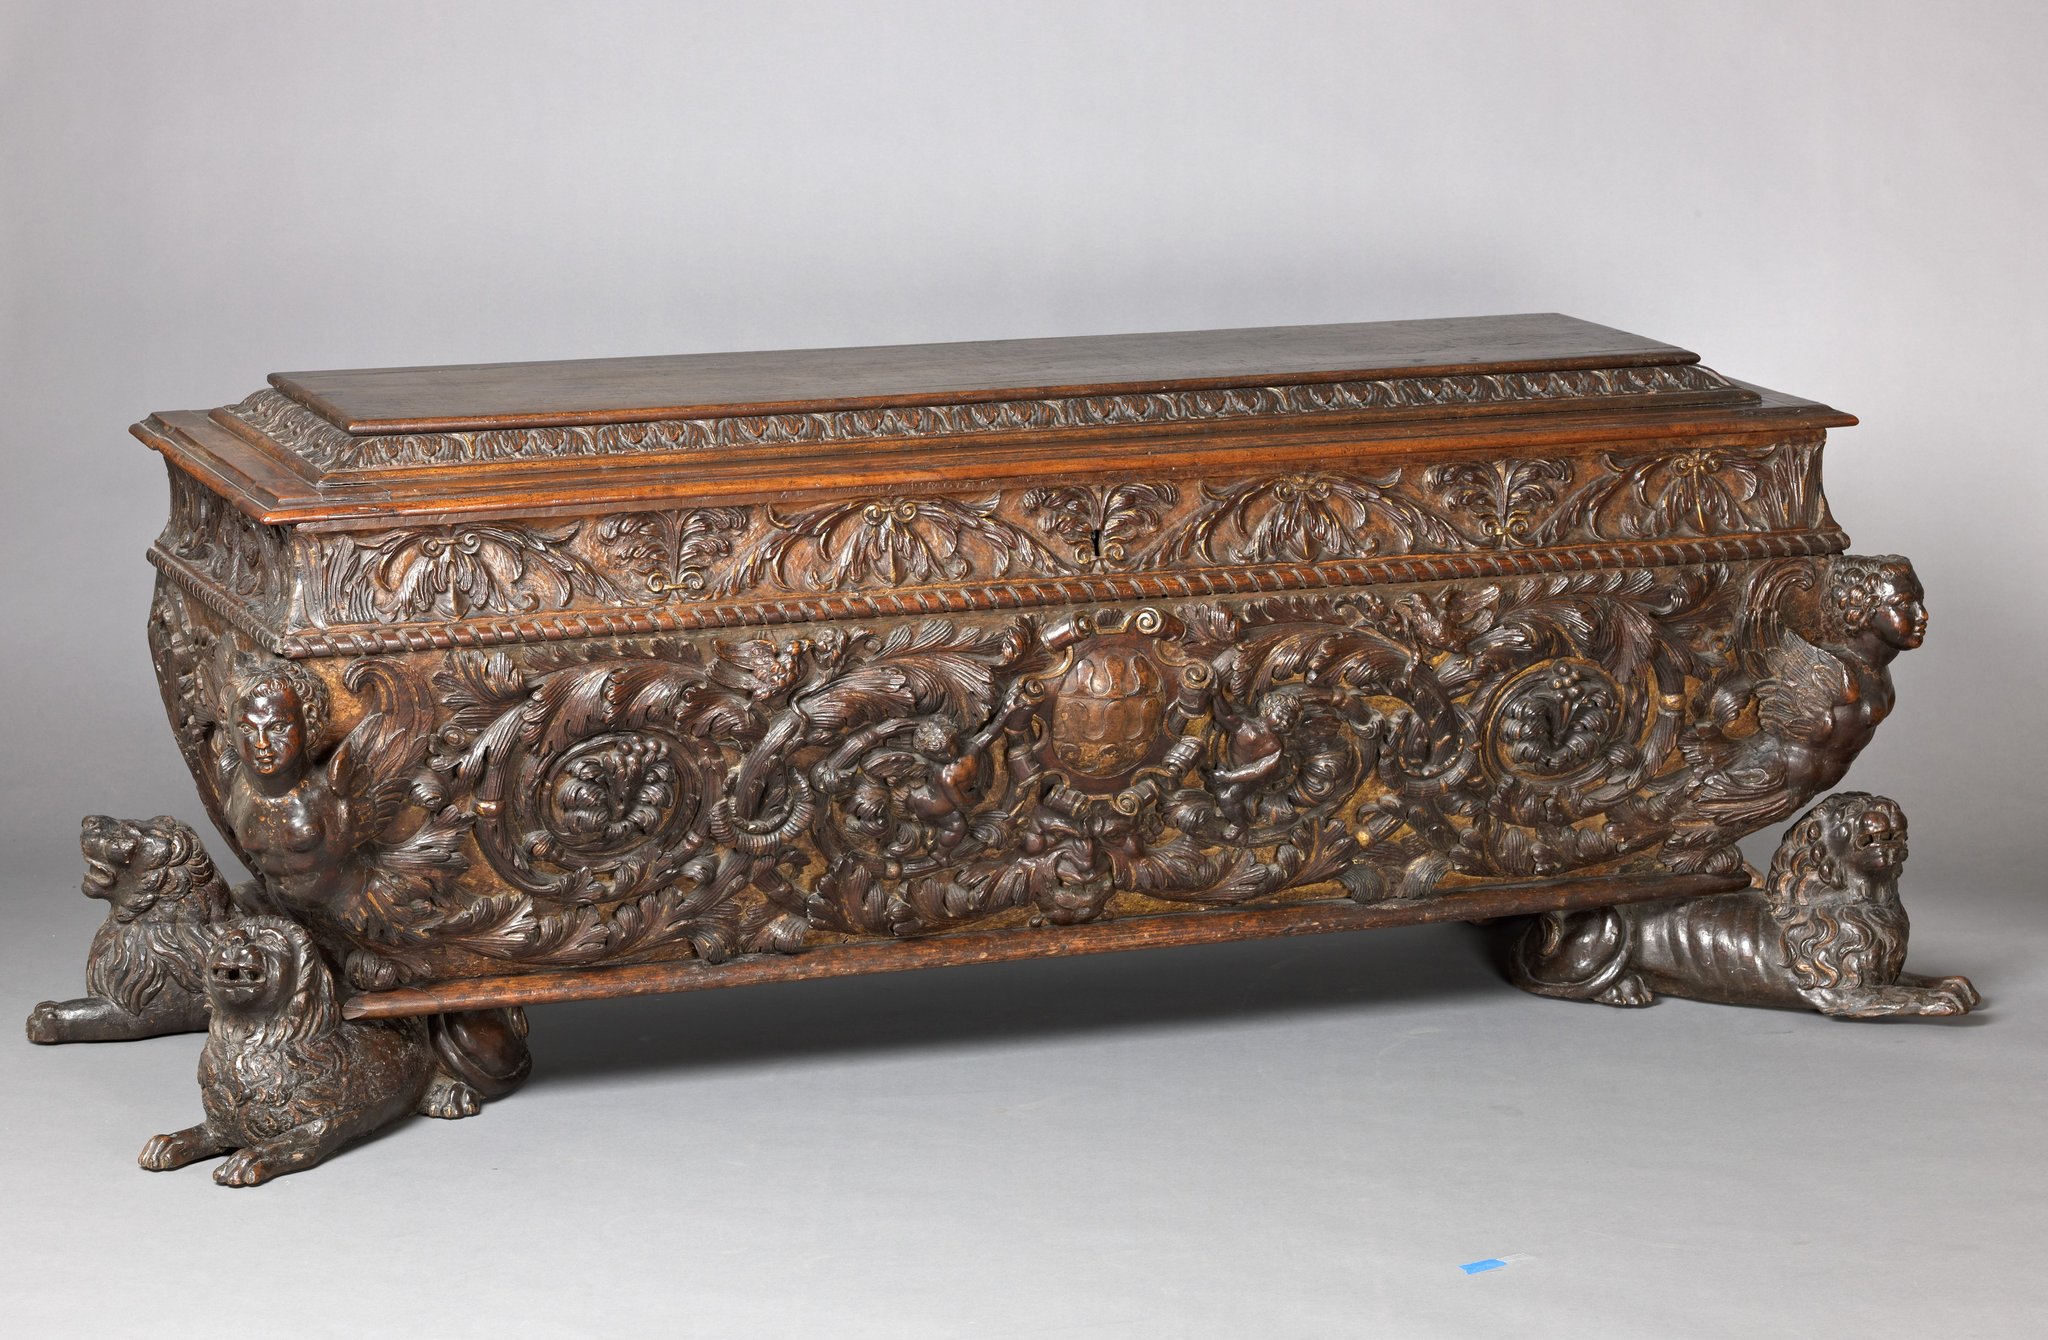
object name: cassone chest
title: Cassone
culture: italian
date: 1550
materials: wood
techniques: carving, gilding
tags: putti,lions